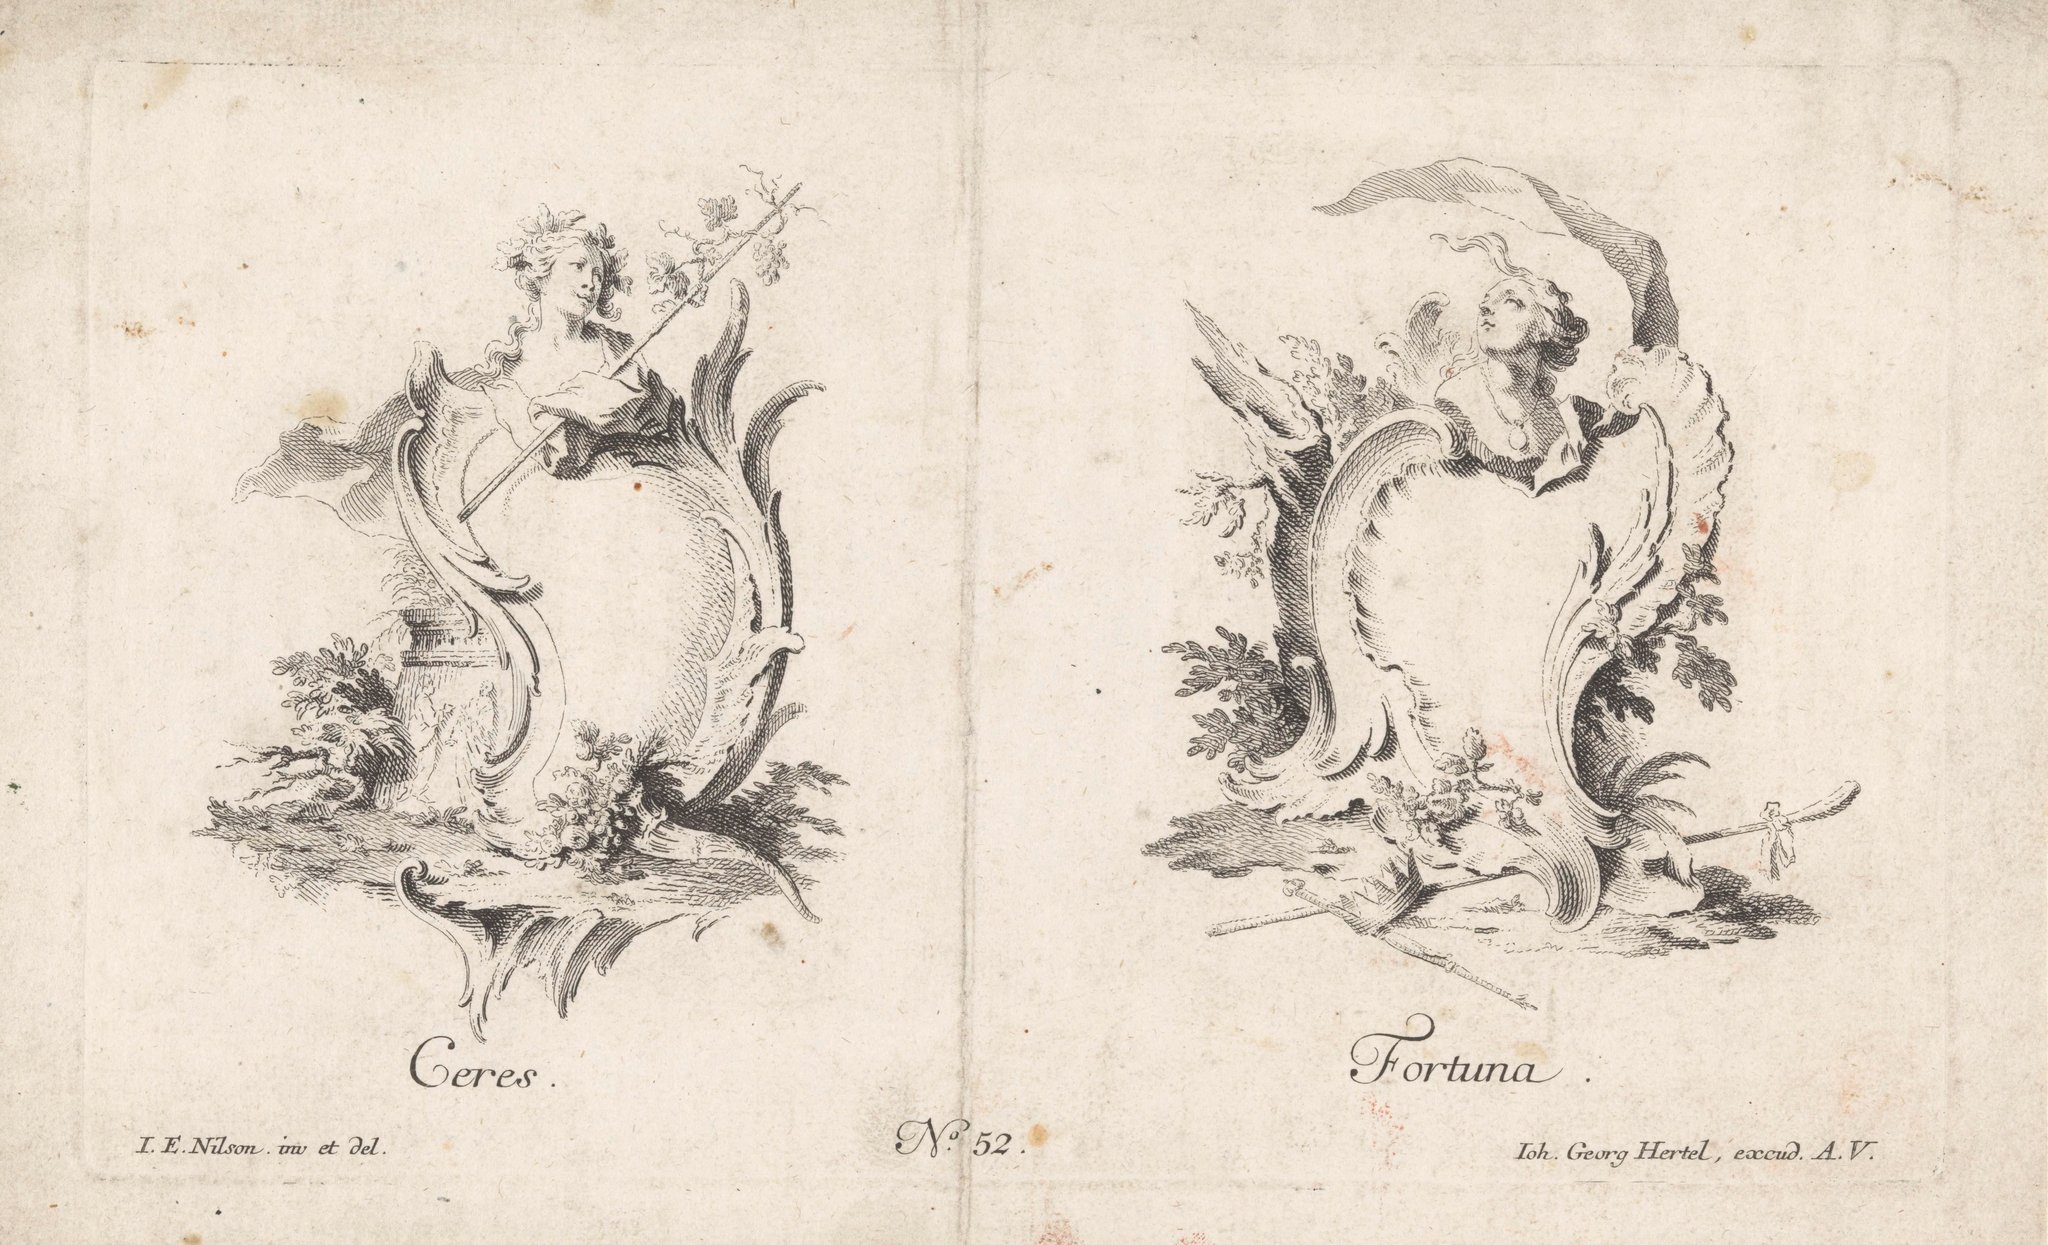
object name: ornament print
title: Ceres en Fortuna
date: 1731-1775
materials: paper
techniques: engraving, etching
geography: augsburg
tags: specific aspects, allegorical aspects of ceres; ceres as patroness, fortuna as roman personification, ornament ~ cartouche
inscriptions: collector's mark: Lugt 2228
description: Twee cartouches met busten van godinnen. Links Ceres met druivenranken en de hoorn des overvloeds. Rechts Fortuna met een herdersstaf, scepter en kroon. Uitgeversnummer 52.